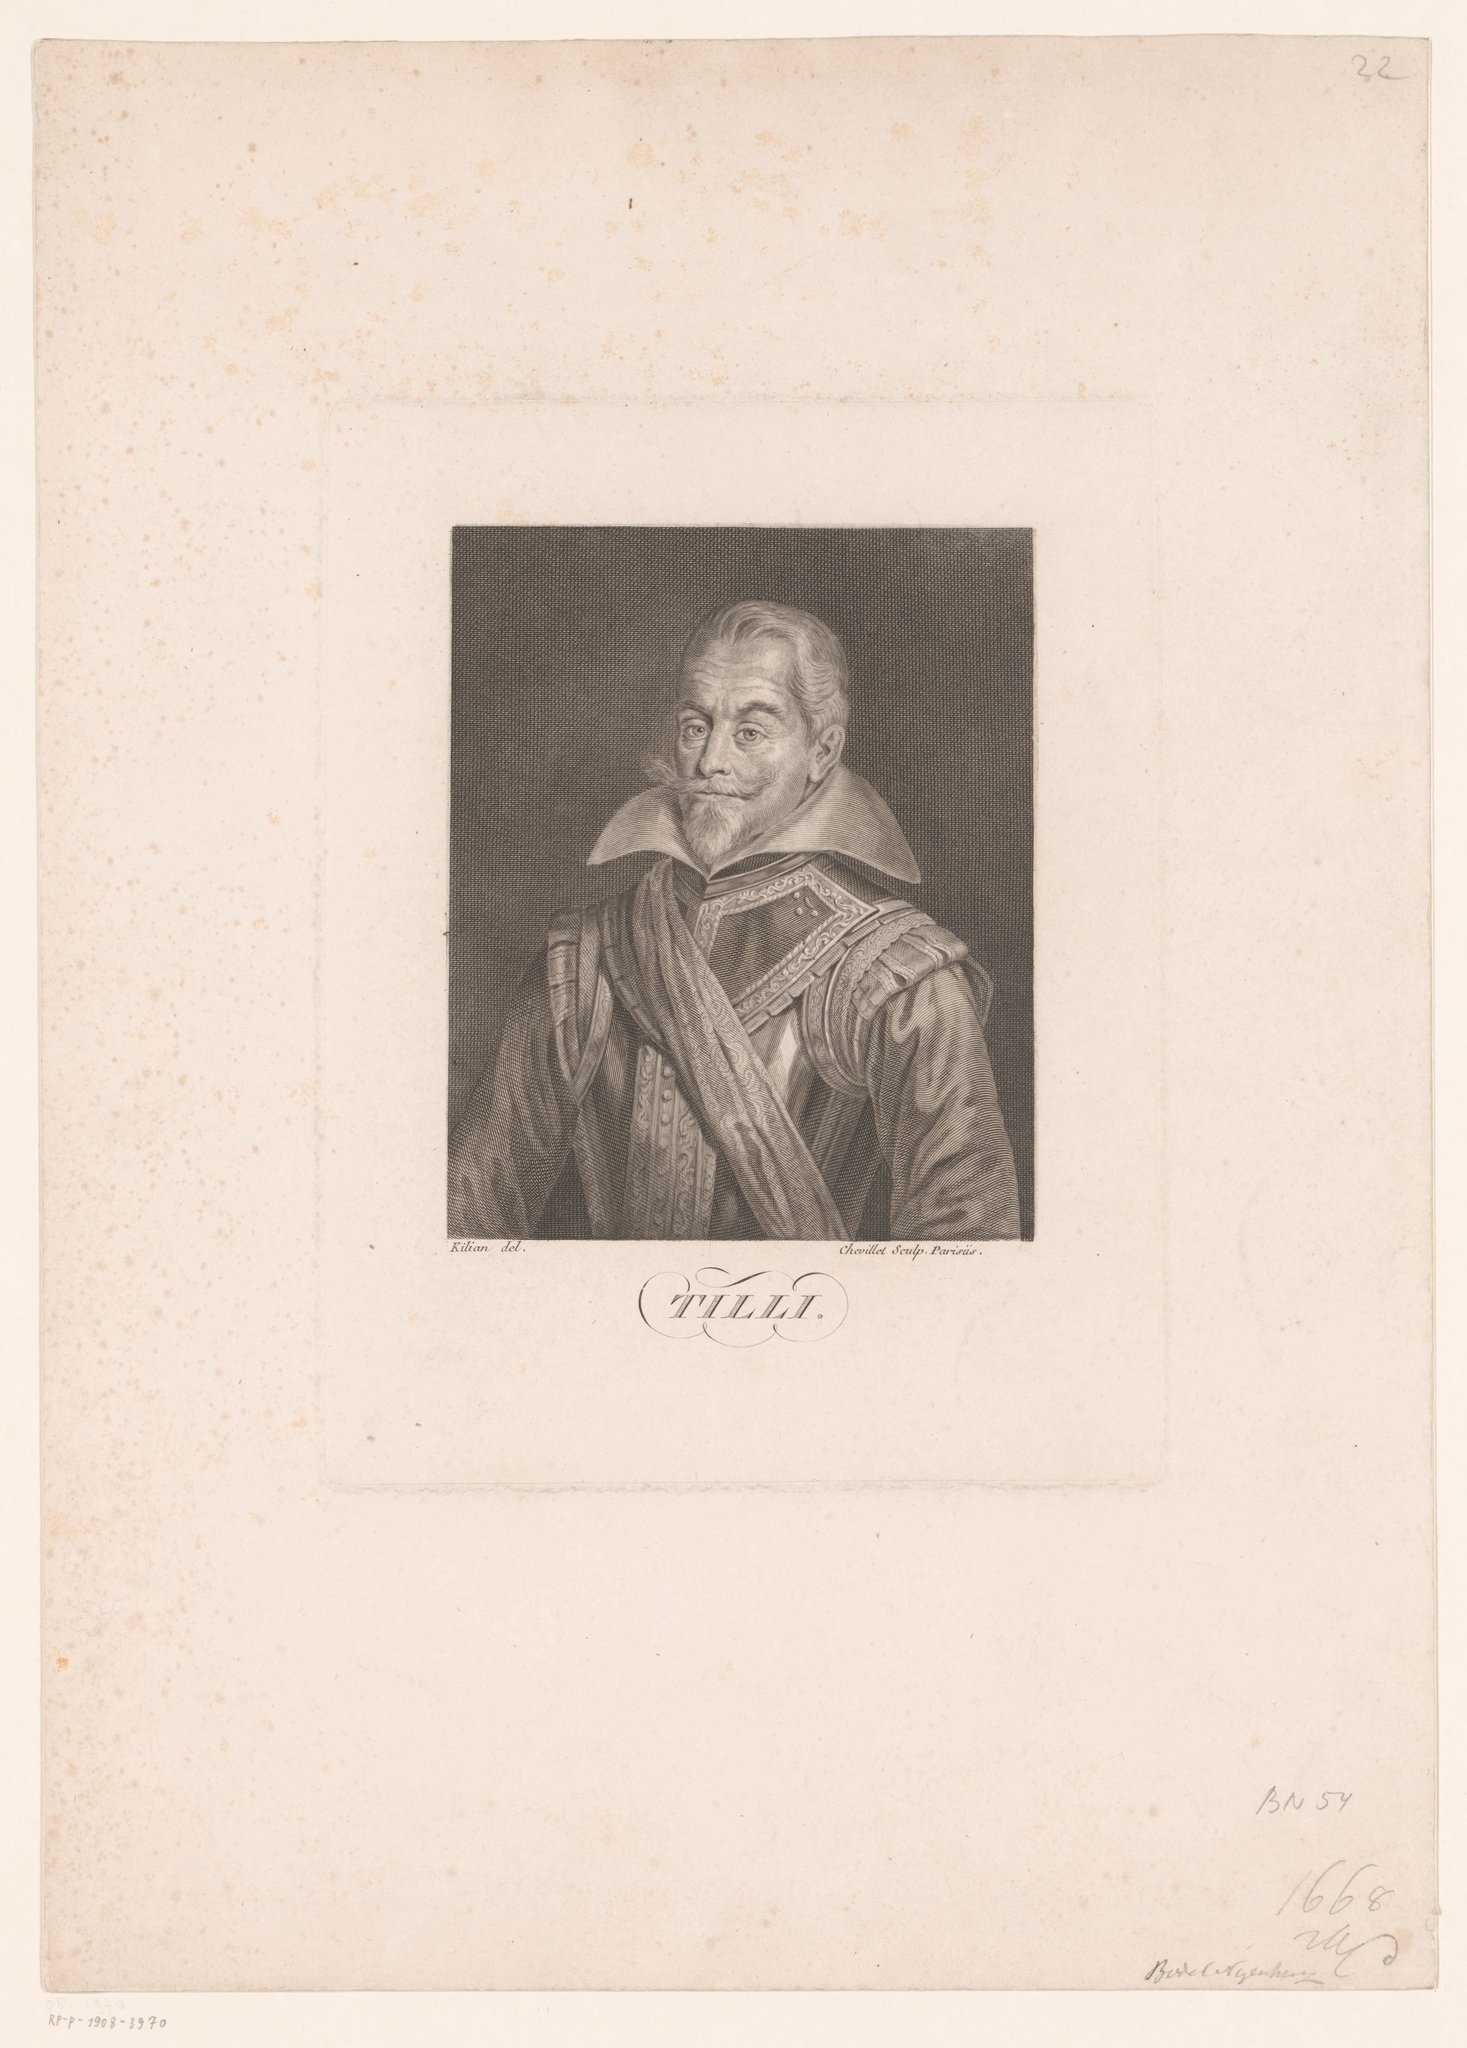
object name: print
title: Portret van Johan t'Serclaes van Tilly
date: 1783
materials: paper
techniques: engraving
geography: paris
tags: historical persons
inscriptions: collector's mark: Lugt 2228